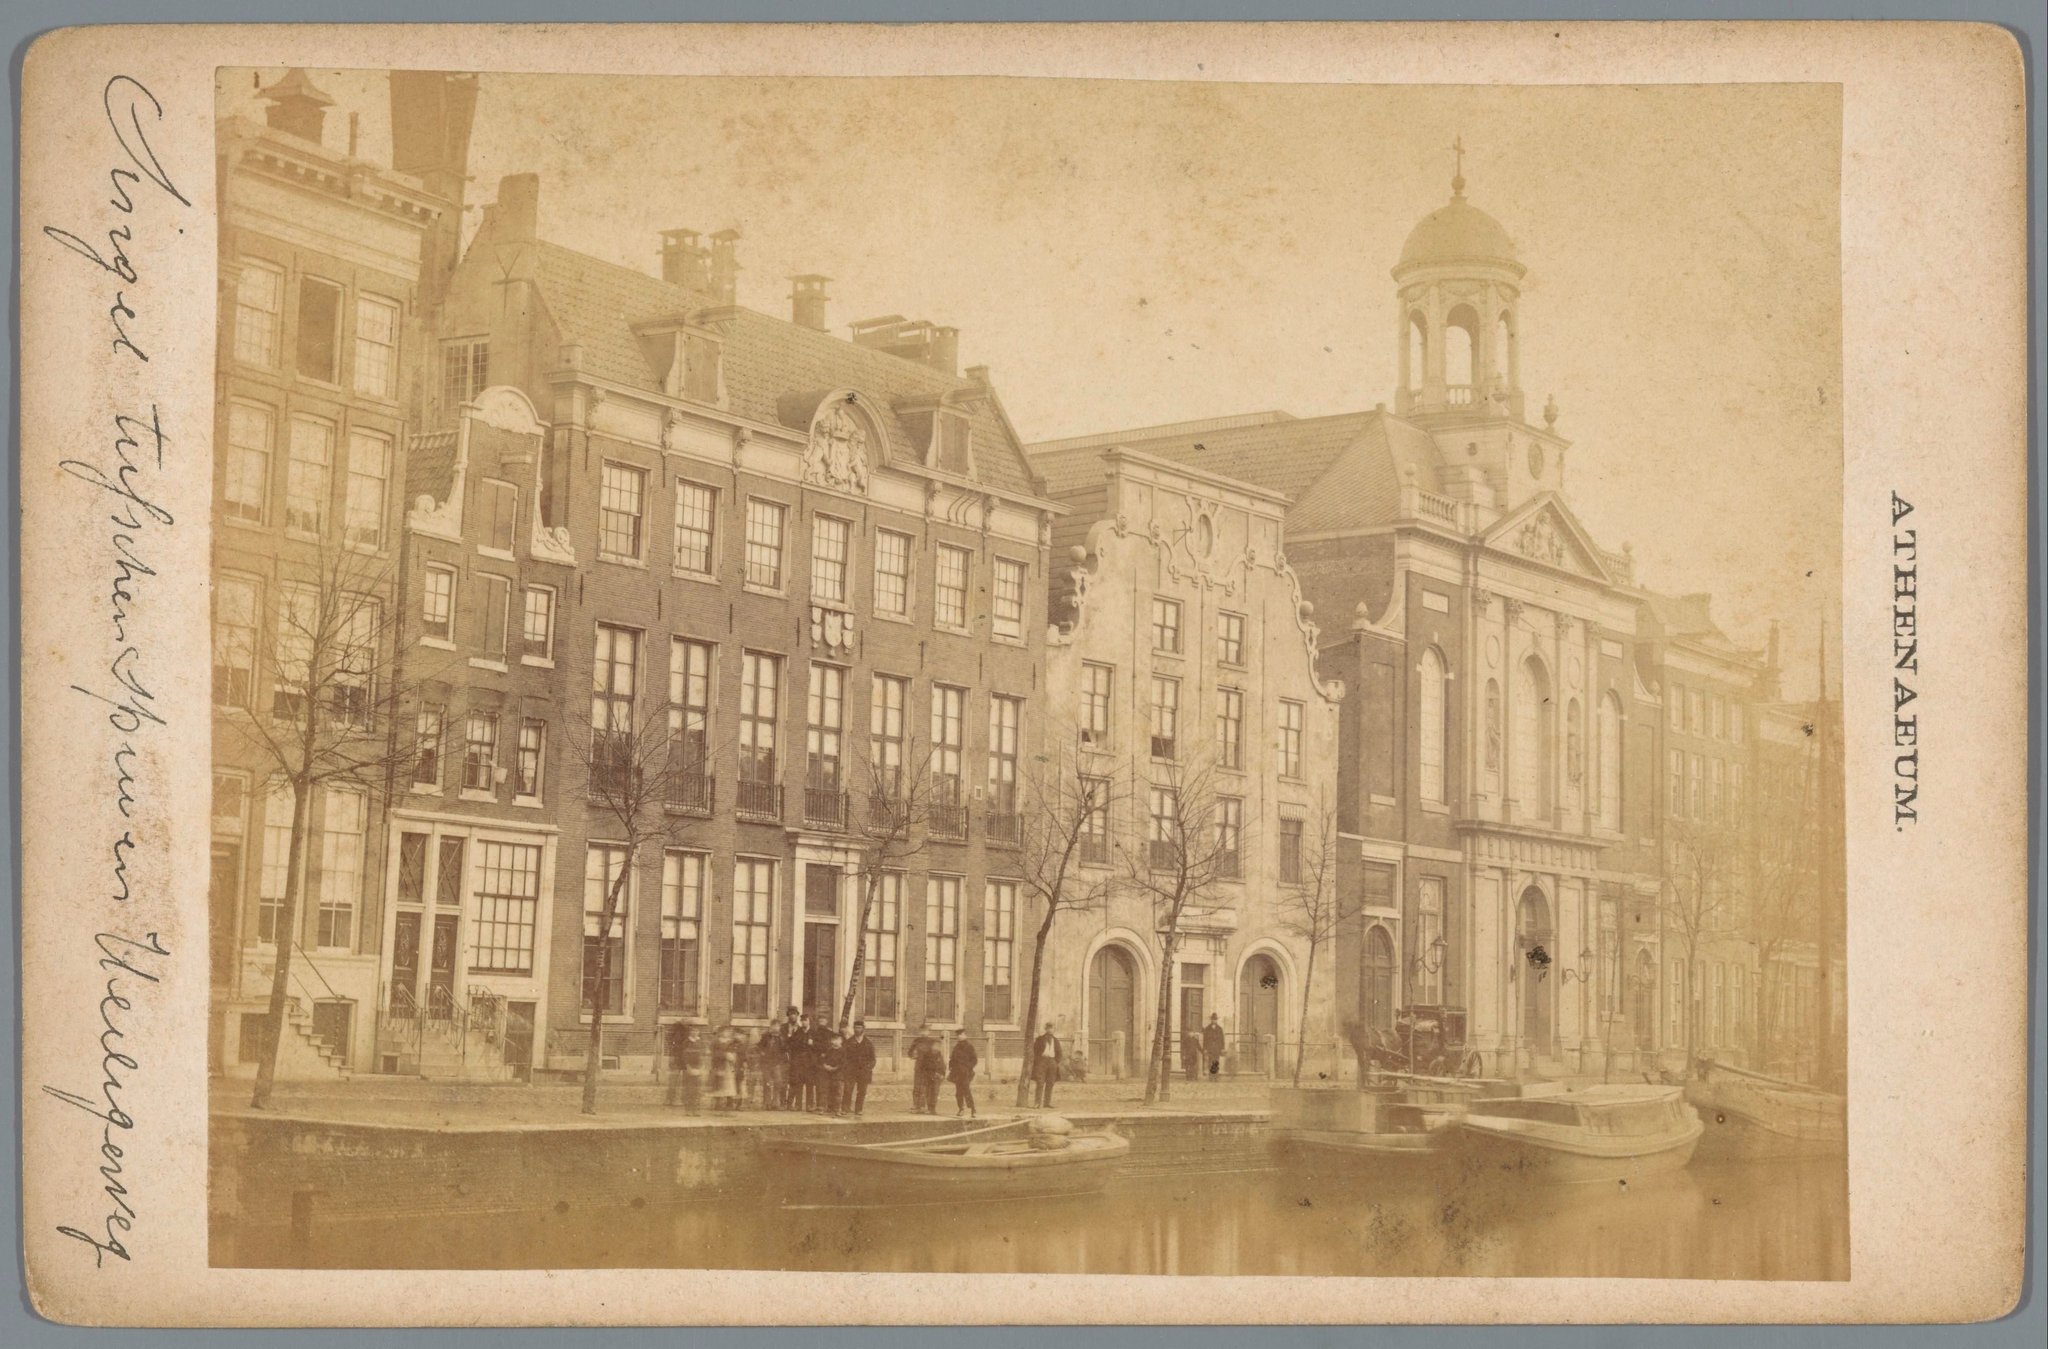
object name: cabinet photograph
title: Gezicht op de Singel in Amsterdam tussen het Spui en de Heiligeweg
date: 1850-1900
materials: cardboard, photographic support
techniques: albumen print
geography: amsterdam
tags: canals, waters (in city), street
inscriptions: annotation: ‘Singel tusschen Spui en Heiligeweg’